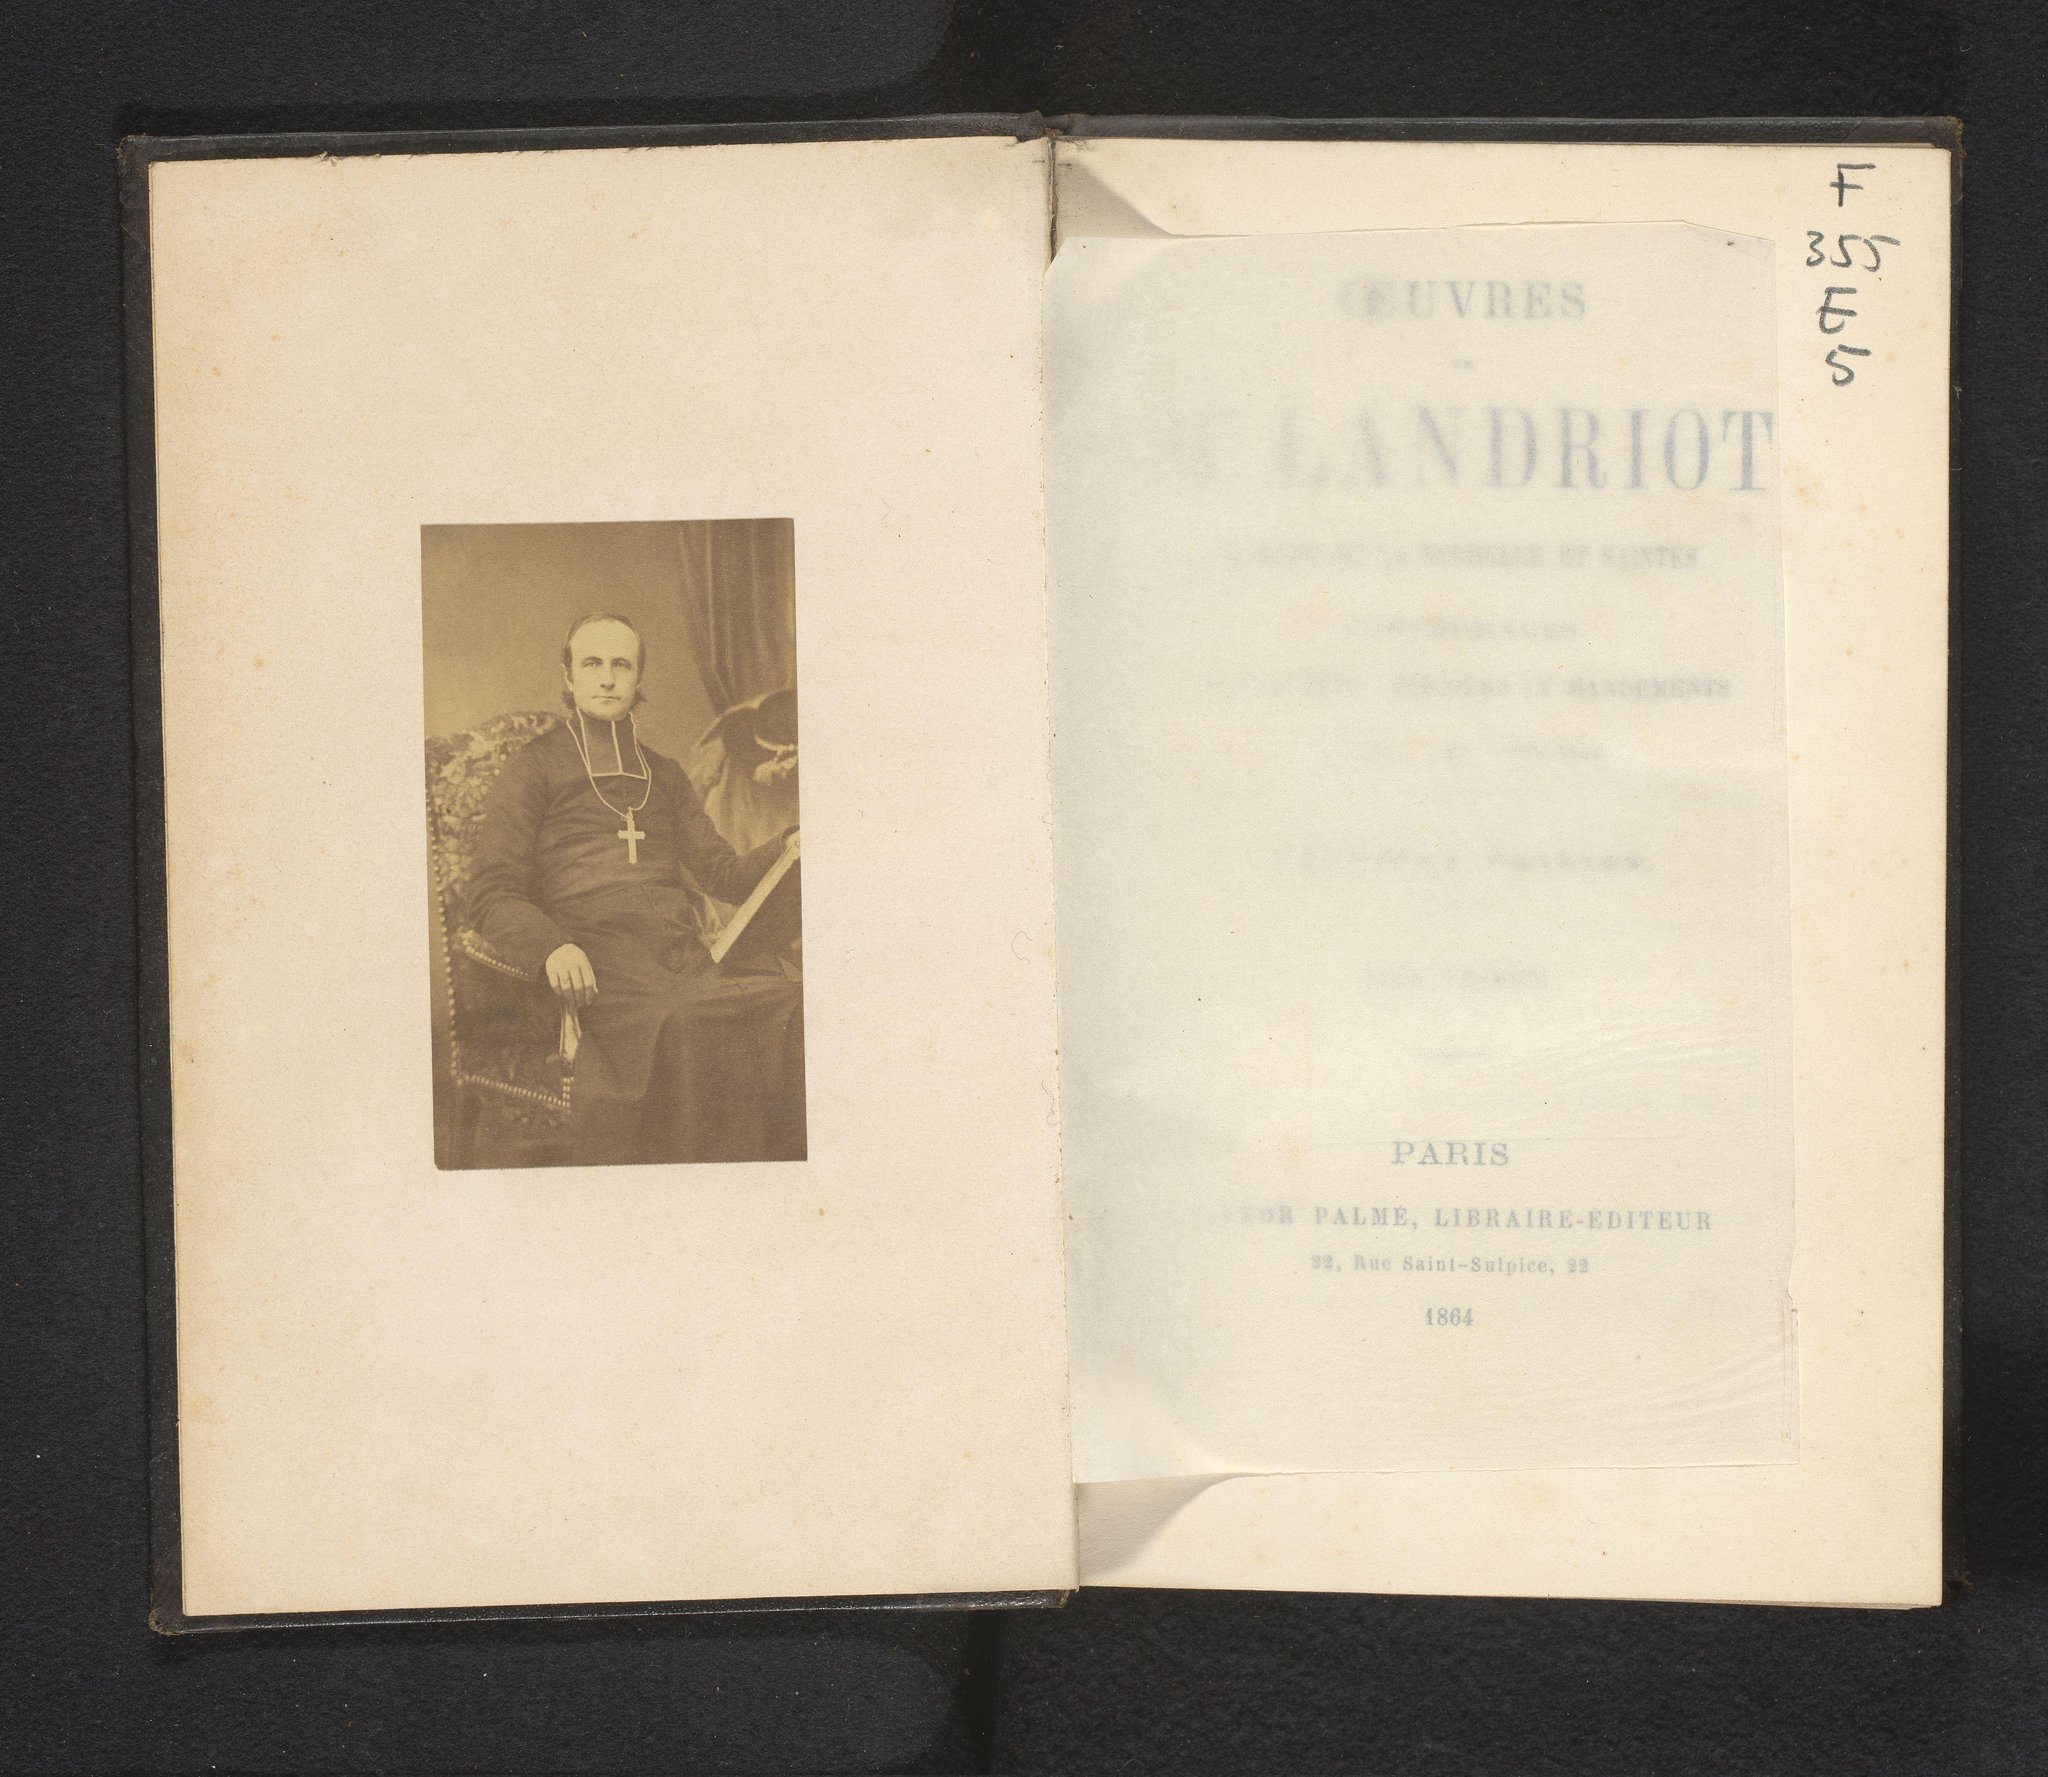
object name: photograph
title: Portret van Jean-François Landriot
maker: Anonymous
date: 1854-1864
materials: photographic support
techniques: albumen print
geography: france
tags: jean-françois landriot, archbishop, bishop, etc. (roman catholic)